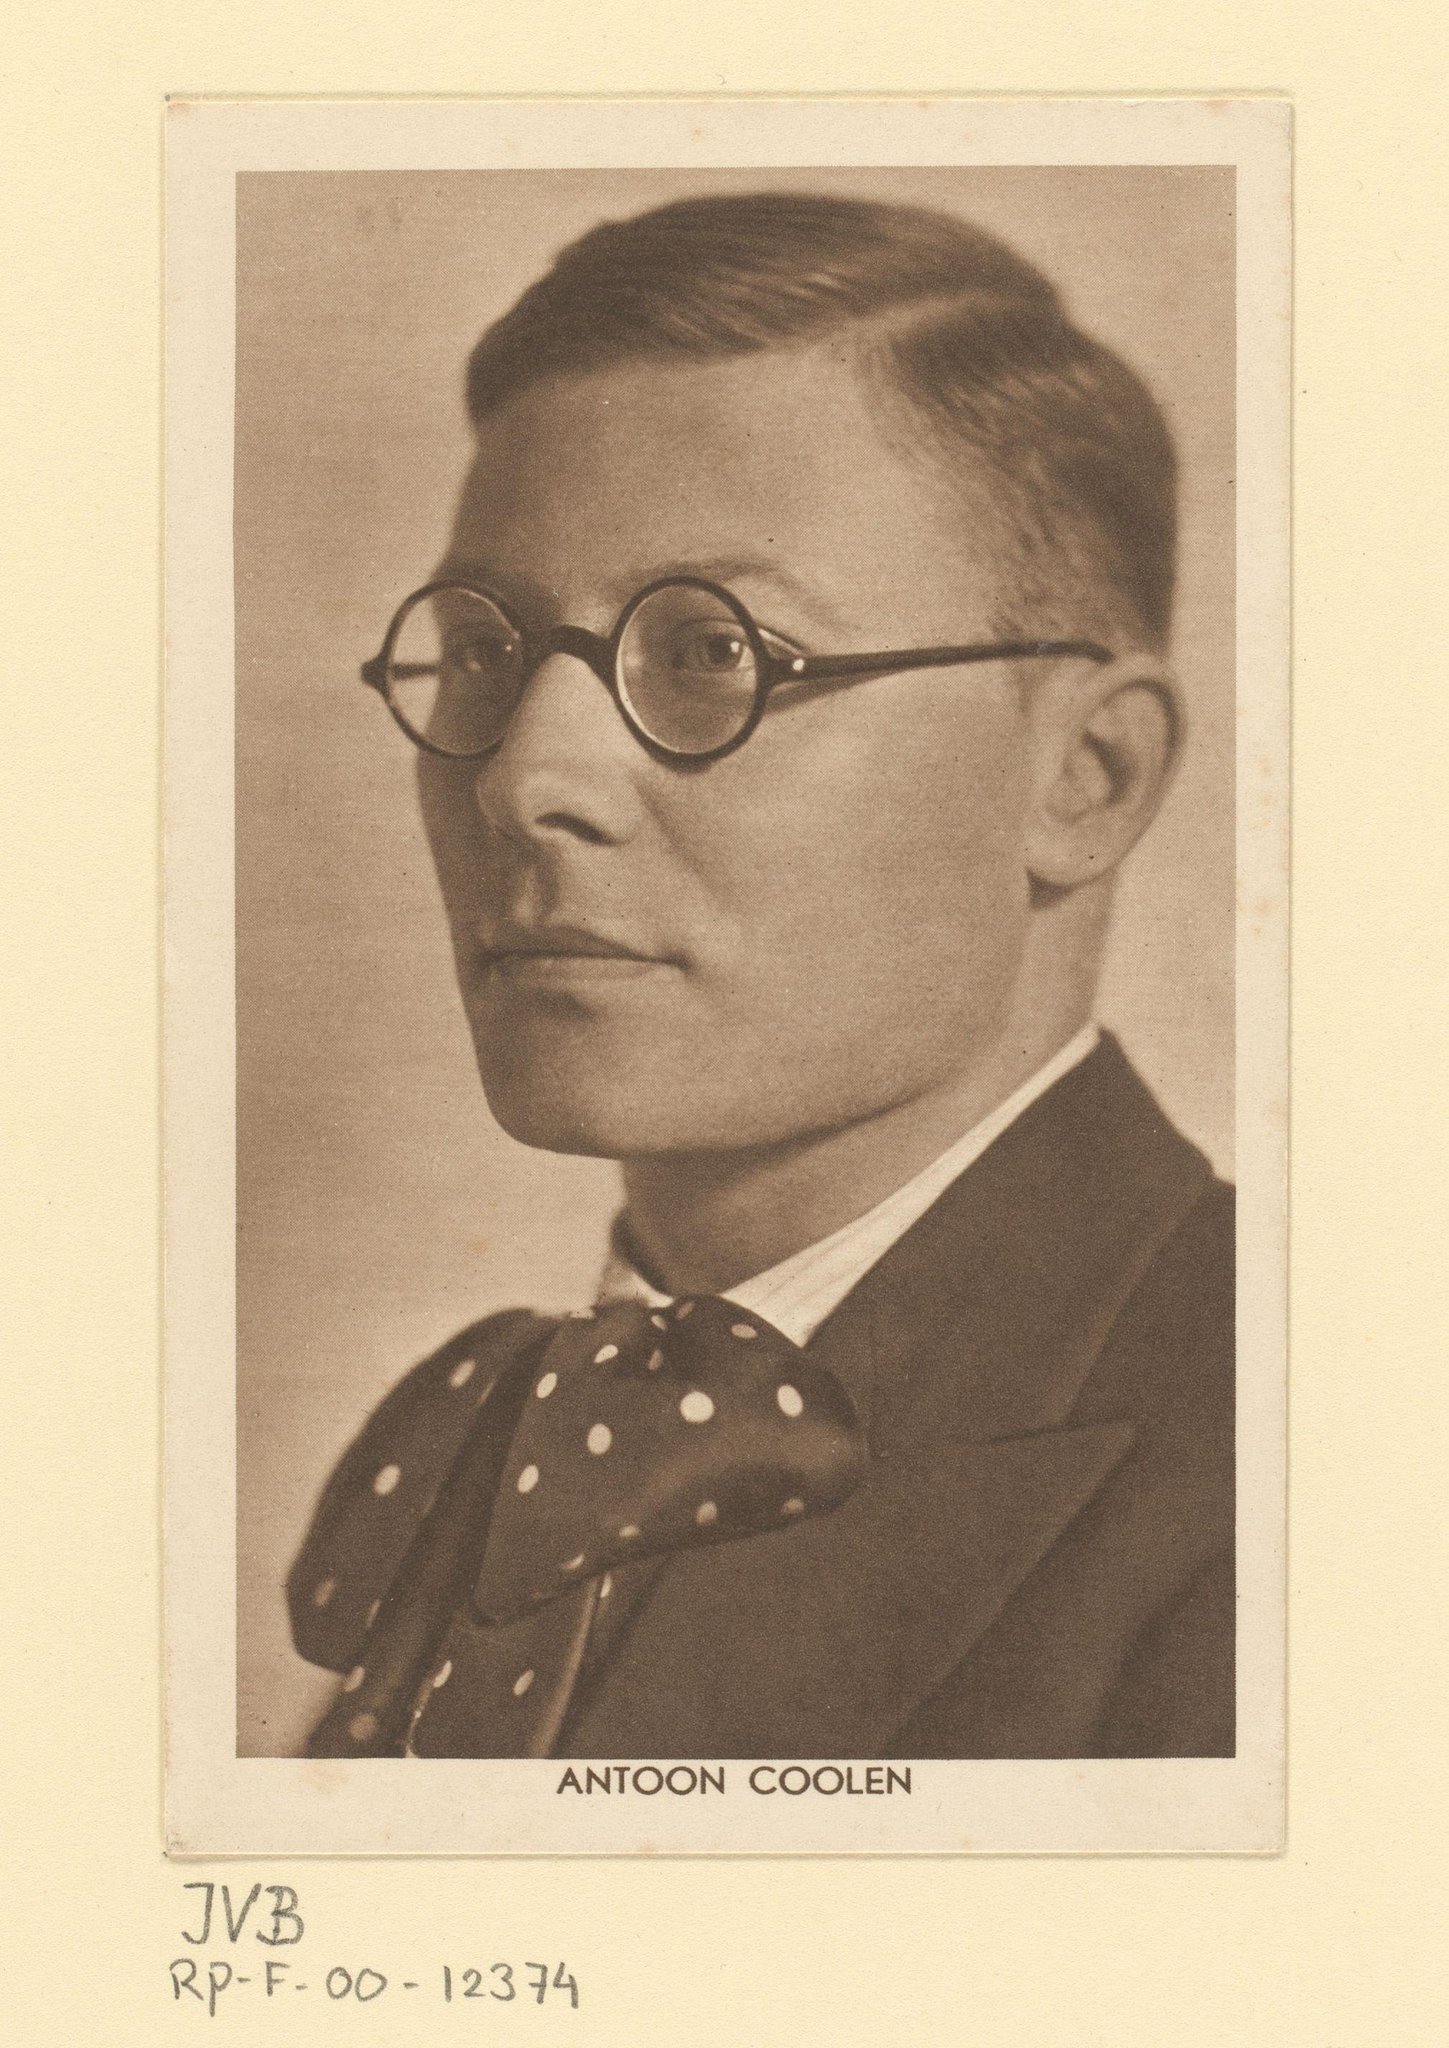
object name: photomechanical print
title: Antoon Coolen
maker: Anonymous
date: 1934-1961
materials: paper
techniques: rotogravure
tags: historical persons, portrait of a writer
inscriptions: stamp: ‘JVB’